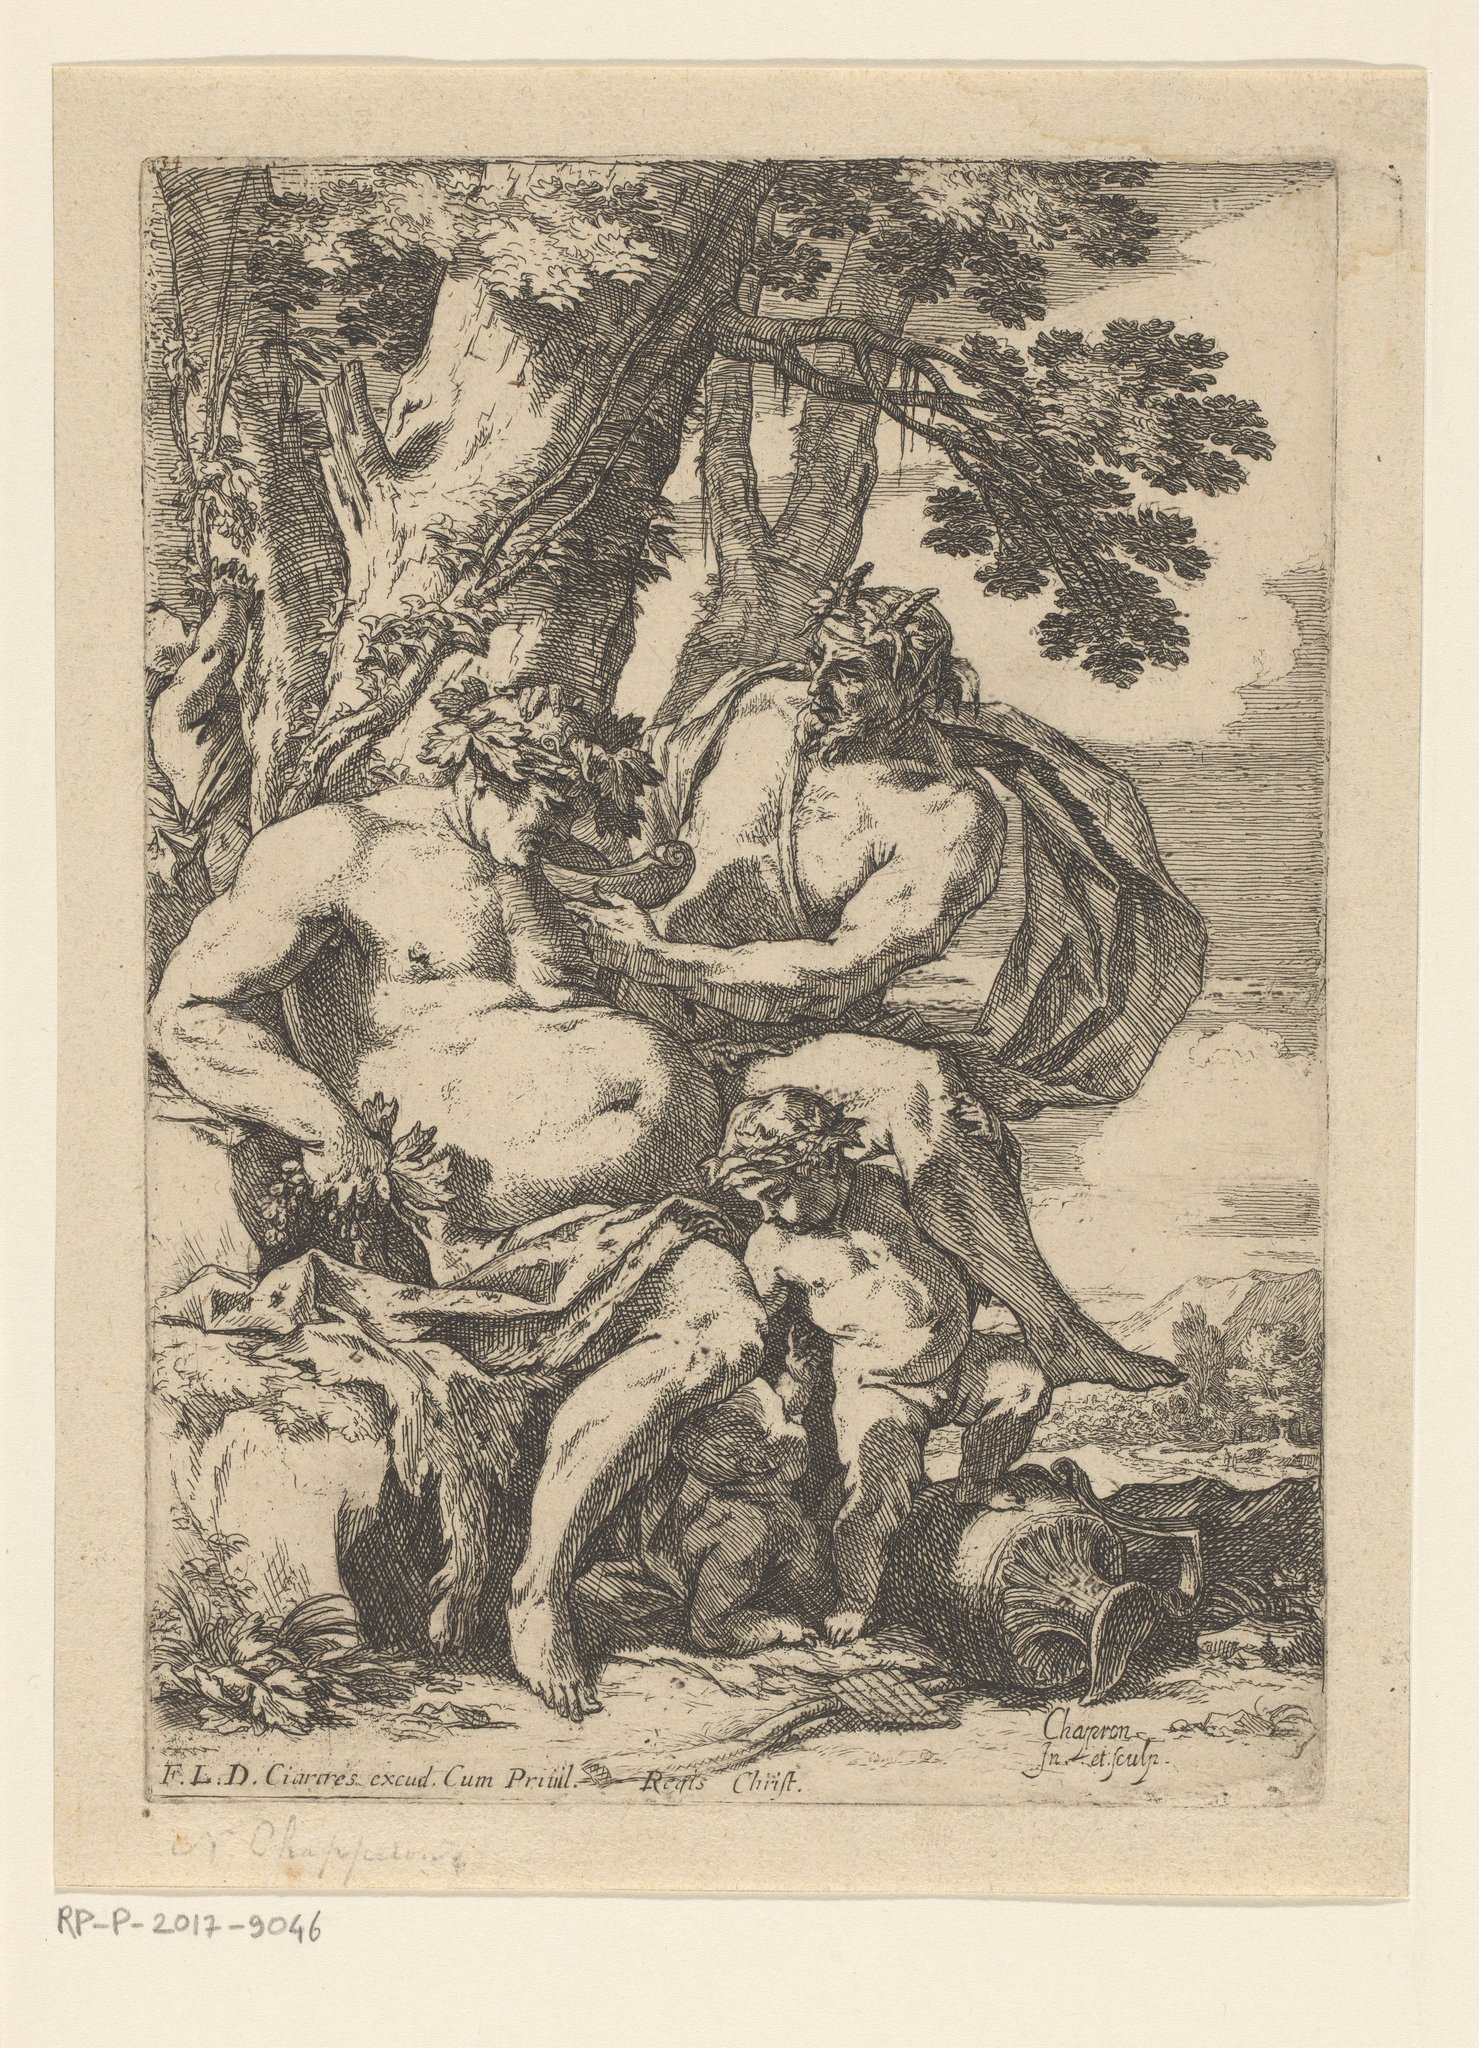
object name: print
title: Dronken Silenus tegen een boom gezeten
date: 1622-1647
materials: paper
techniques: etching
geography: france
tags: (story of) silenus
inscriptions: collector's mark: Lugt 2228